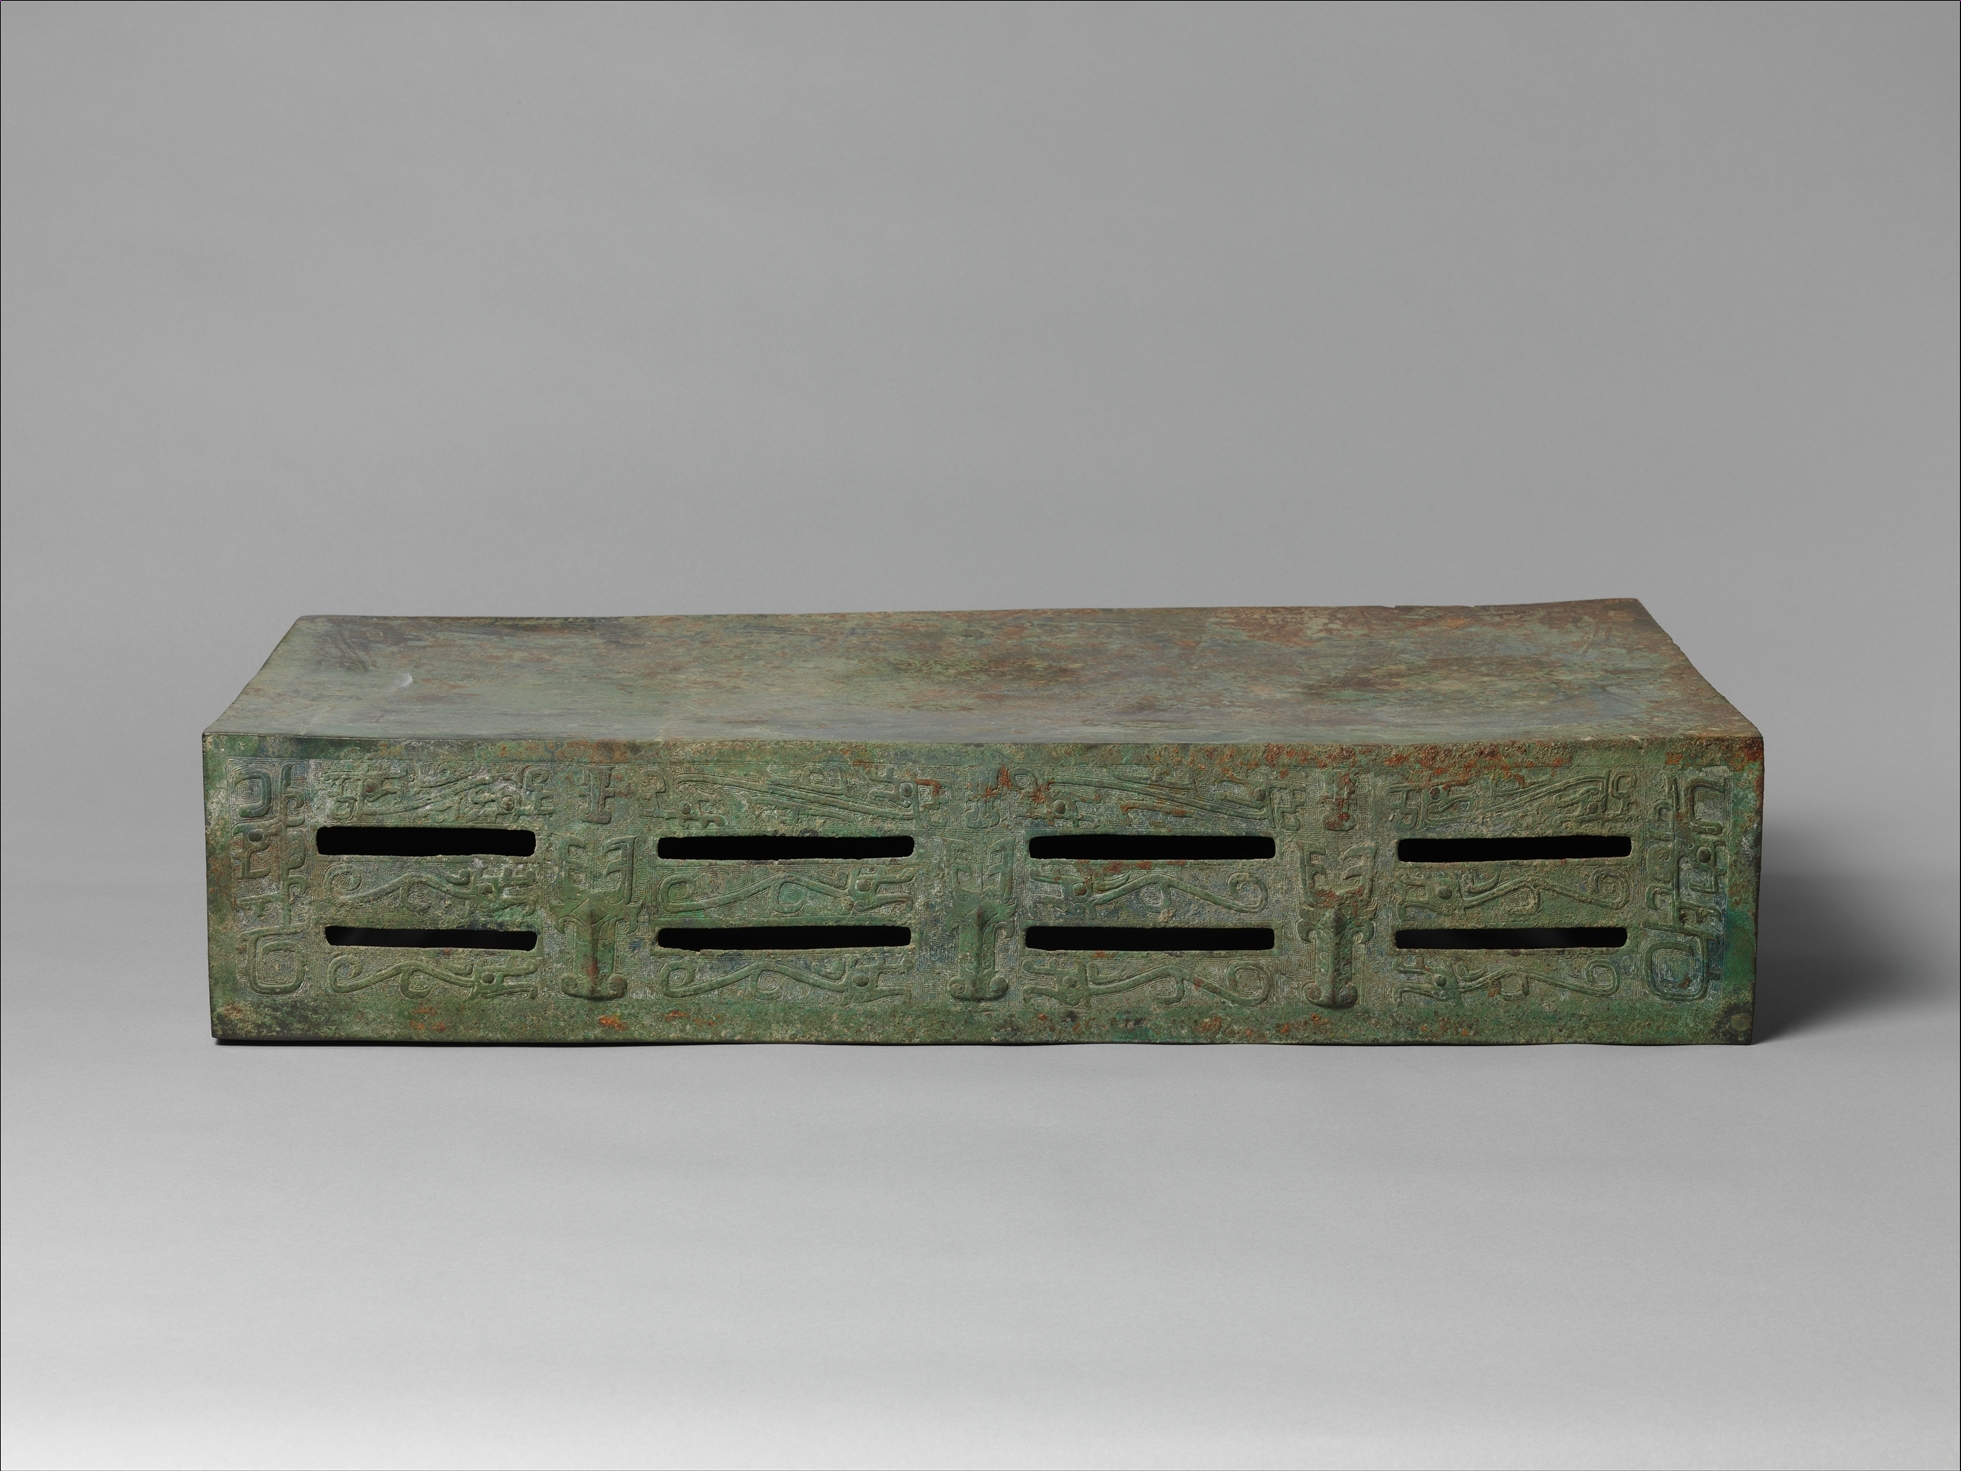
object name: altar table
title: Ritual Altar Table (Jin)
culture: chinese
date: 1034-1001 BCE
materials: bronze